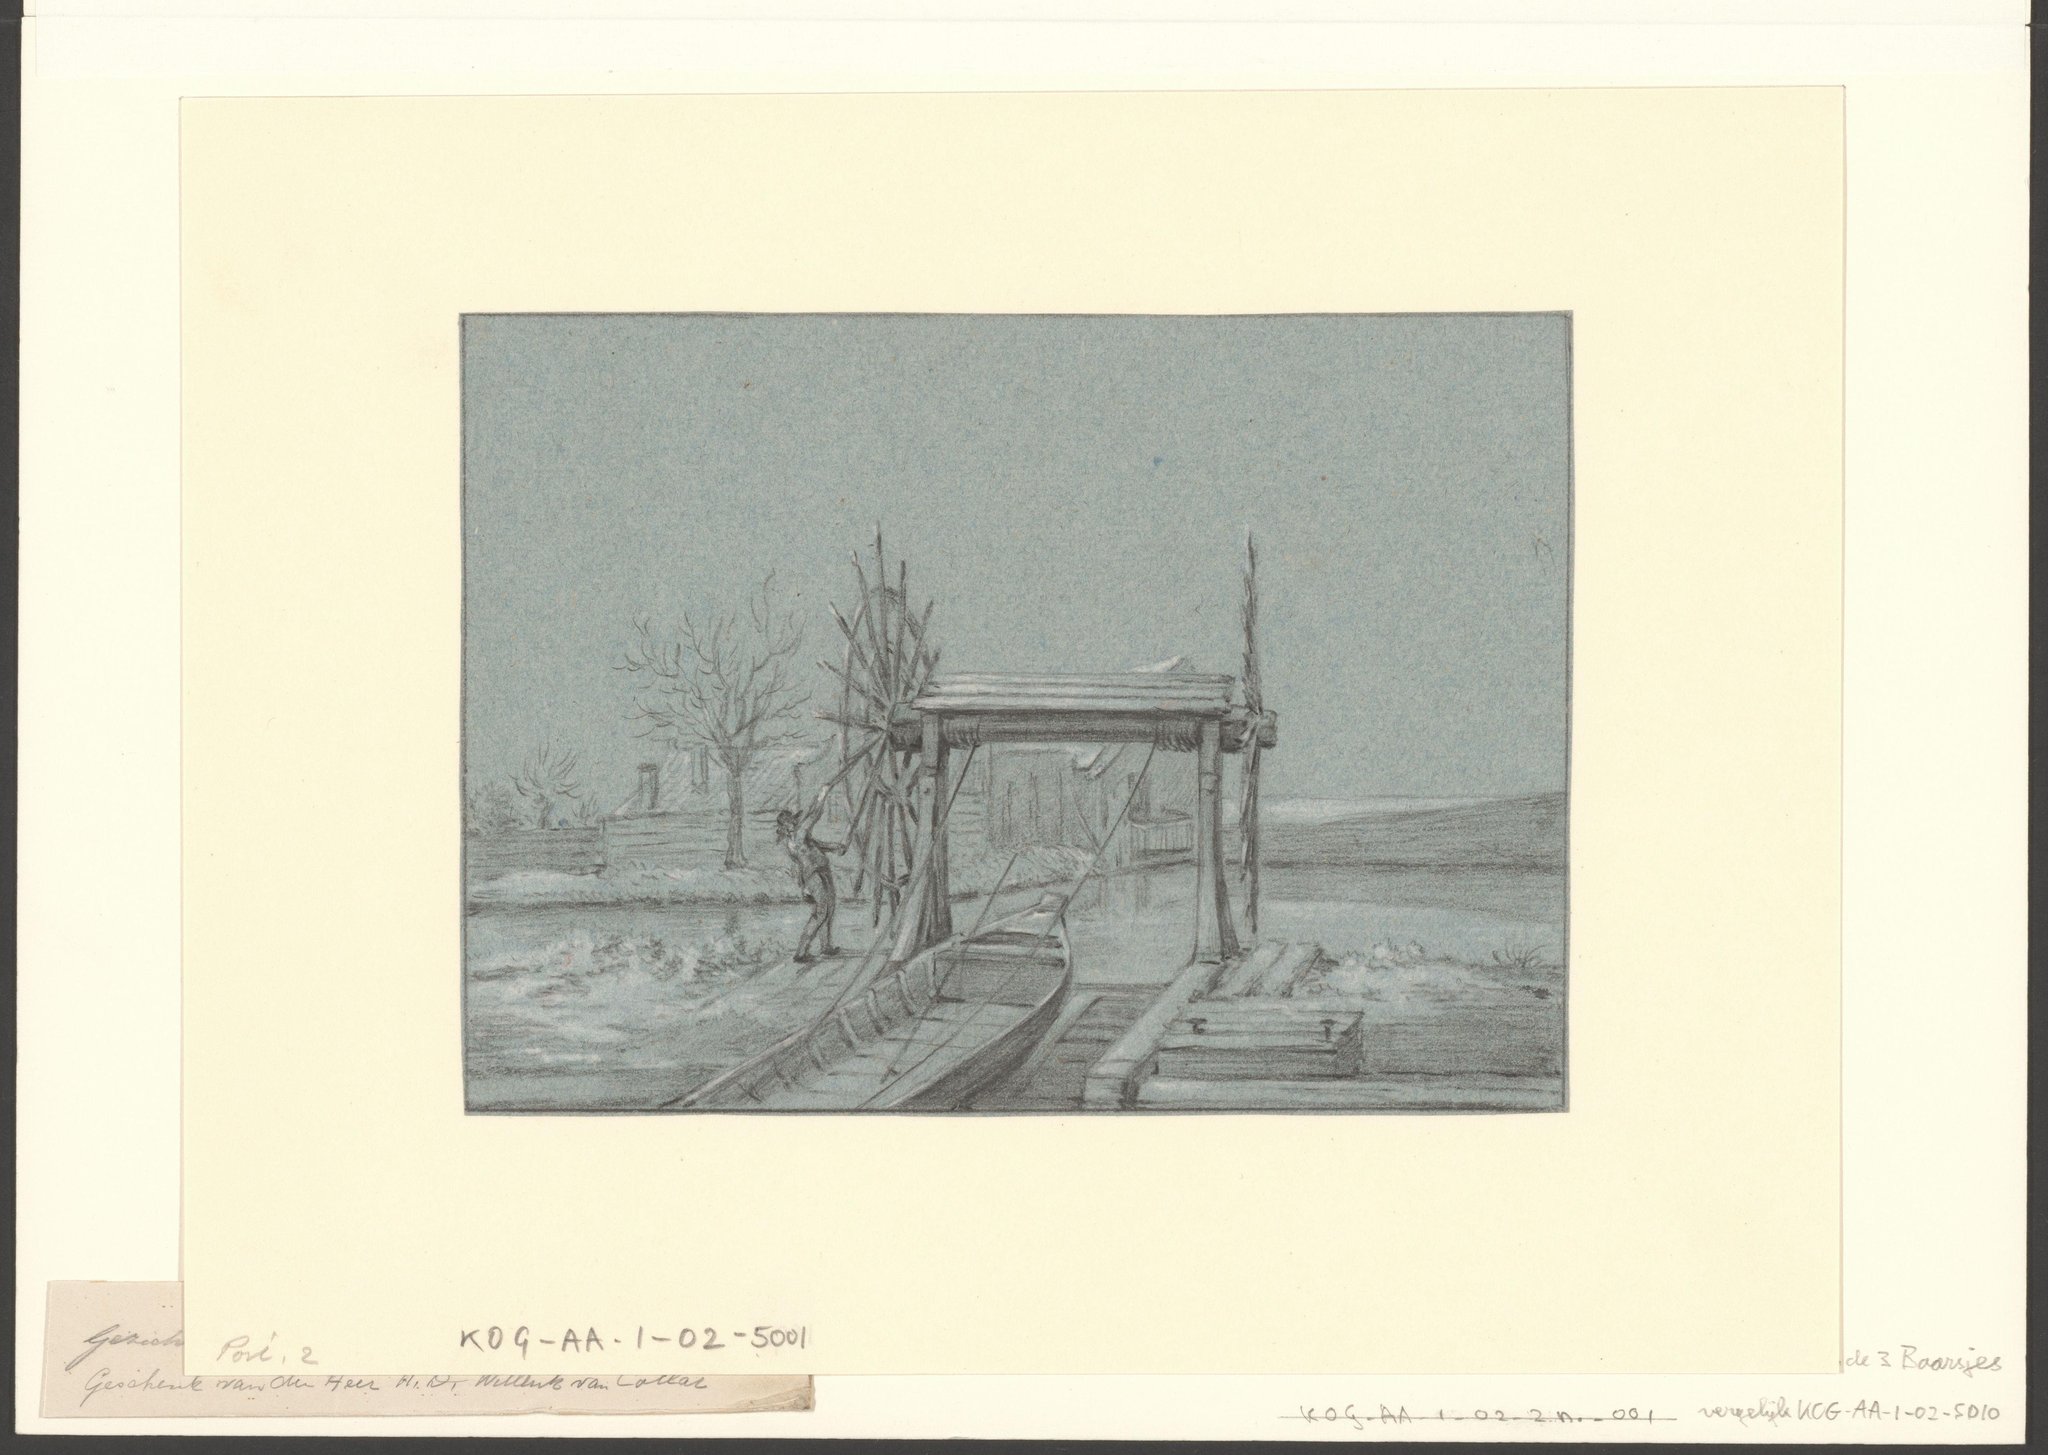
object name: drawing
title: Gezicht op de overhaal aan de Kostverlorenkade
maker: Anonymous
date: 1700-1799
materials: chalk, paper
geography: amsterdam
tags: city-view in general; 'veduta', canal, rolling bridge (dutch: 'overtoom')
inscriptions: inscription: ‘Gezicht op Amsterdam van het Tolhuis / Geschenk van den Heer H.D. Willink van Collar’, inscription: ‘Port. 2’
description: Onderwerpsrubriek binnen de Atlas Amsterdam: Kostverloren Wetering.